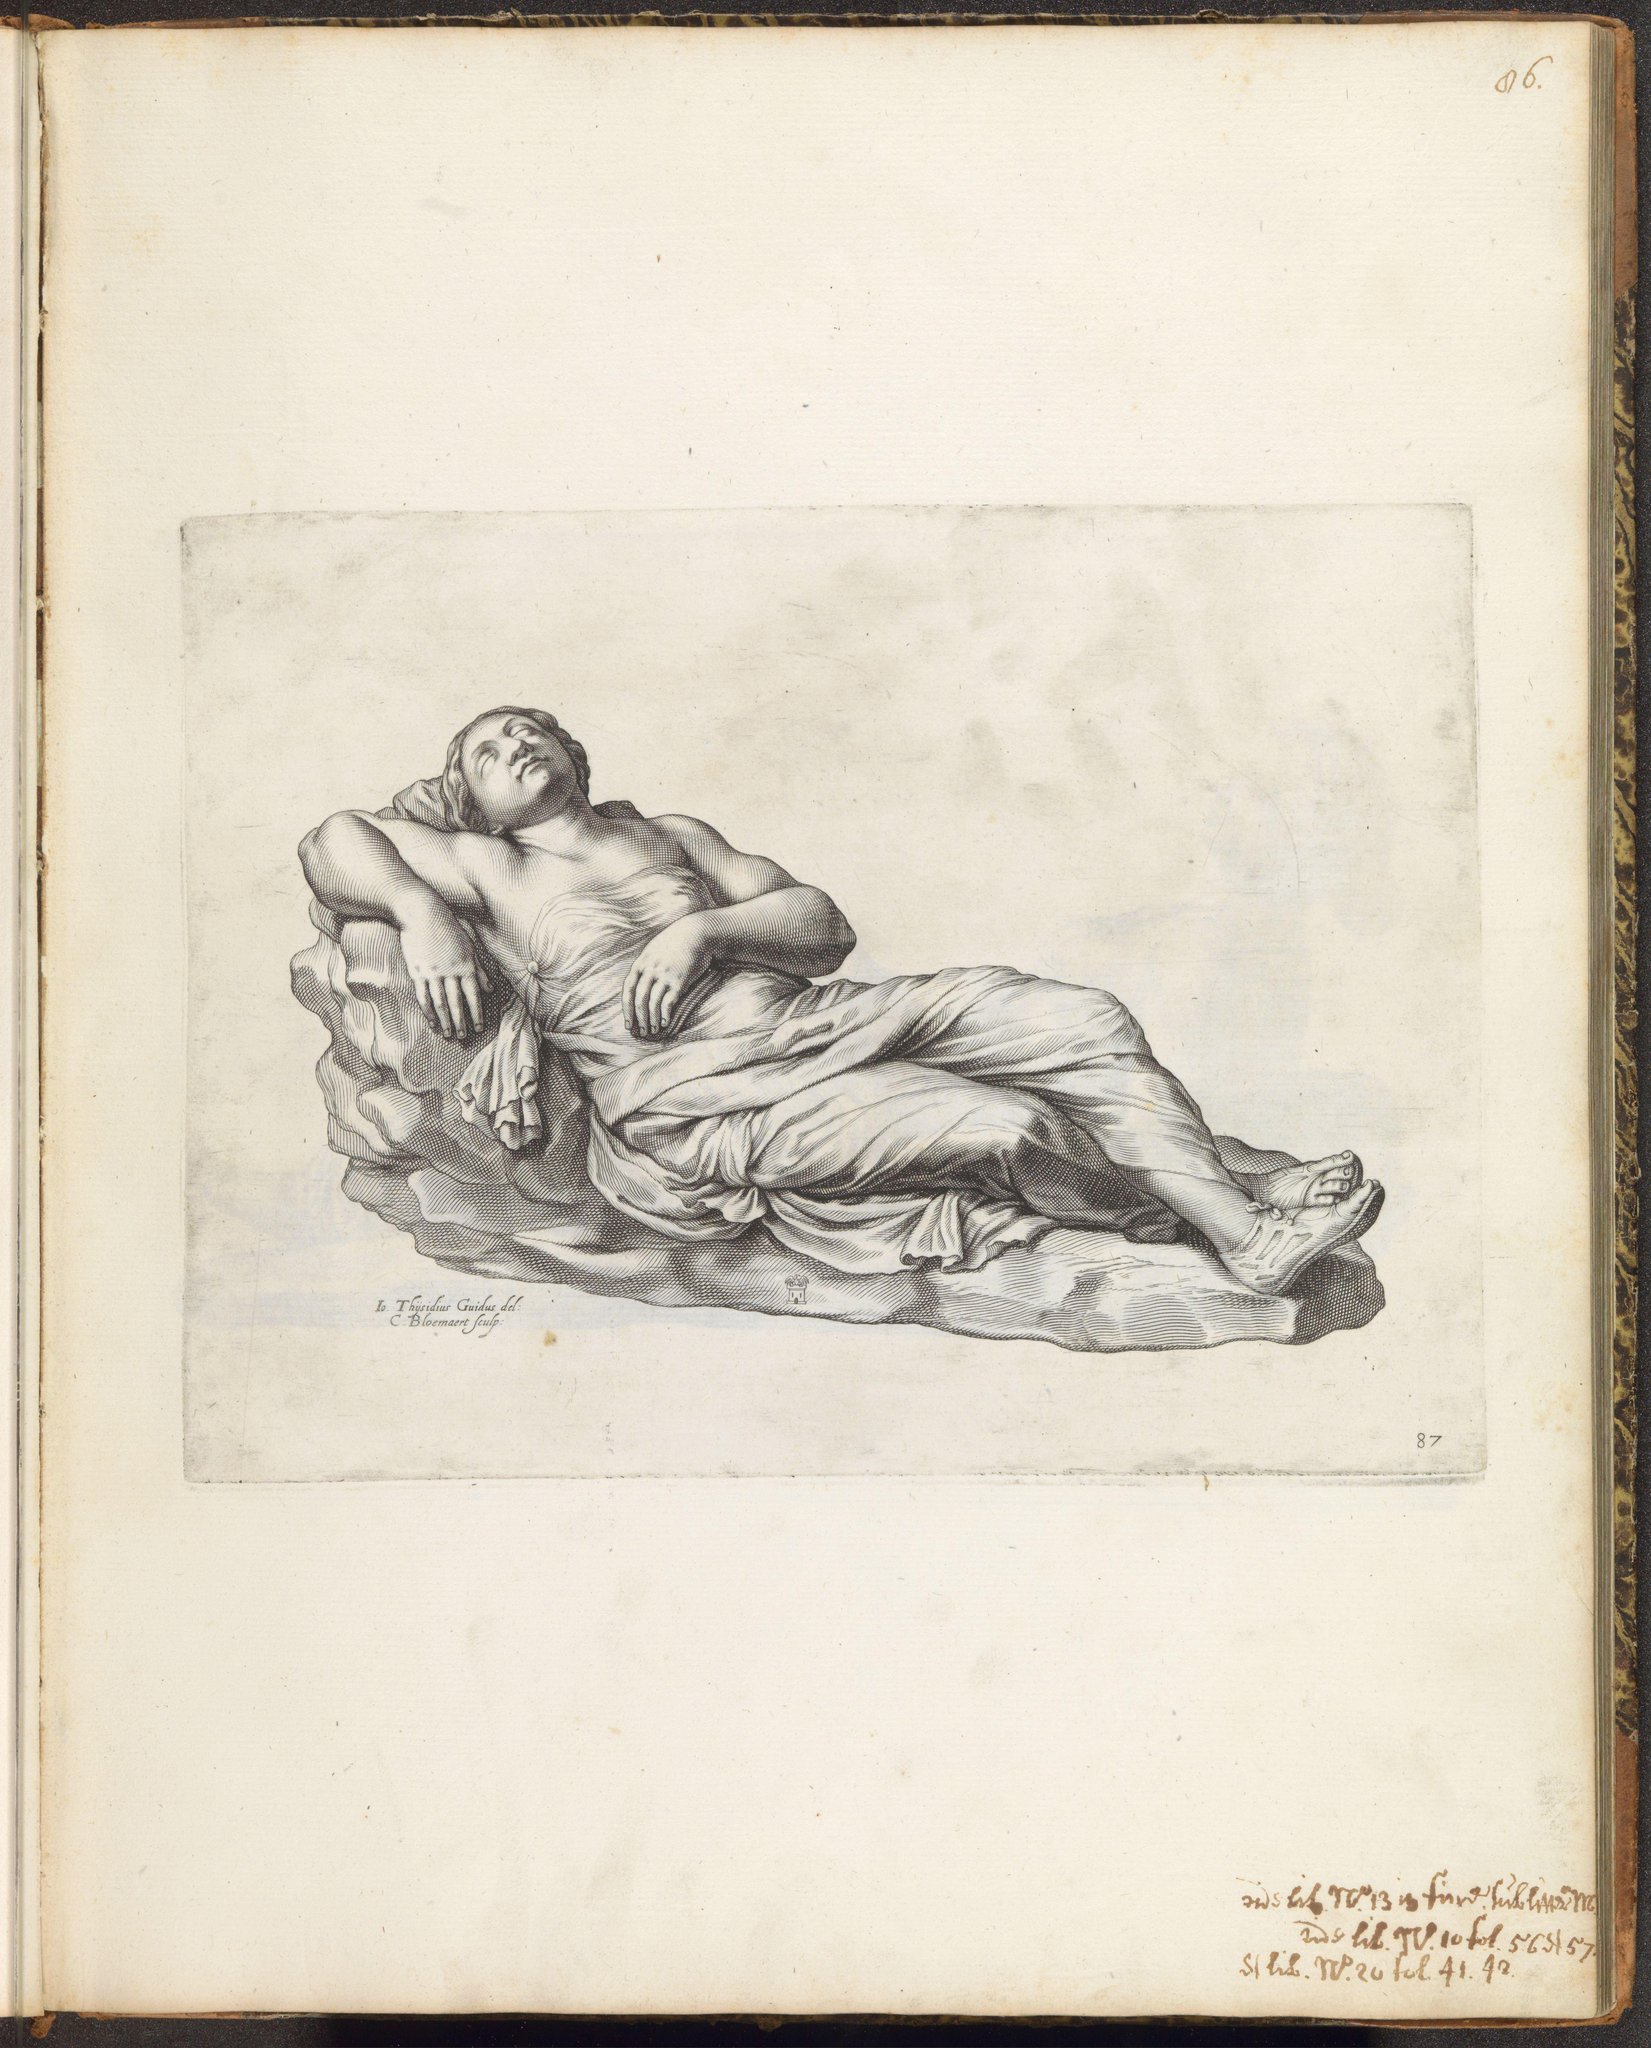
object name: print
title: Slapende vrouw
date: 1636-1647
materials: paper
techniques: engraving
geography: rome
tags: piece of sculpture, reproduction of a piece of sculpture, female persons from classical history (+ full length)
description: Beeld van een liggende slapende vrouw. Op de sokkel het wapenschild van Vincenzo Giustiniani. Prent maakt deel uit van een album met een serie prenten naar de sculpturen in de verzameling in de Galleria Giustiniani te Rome.